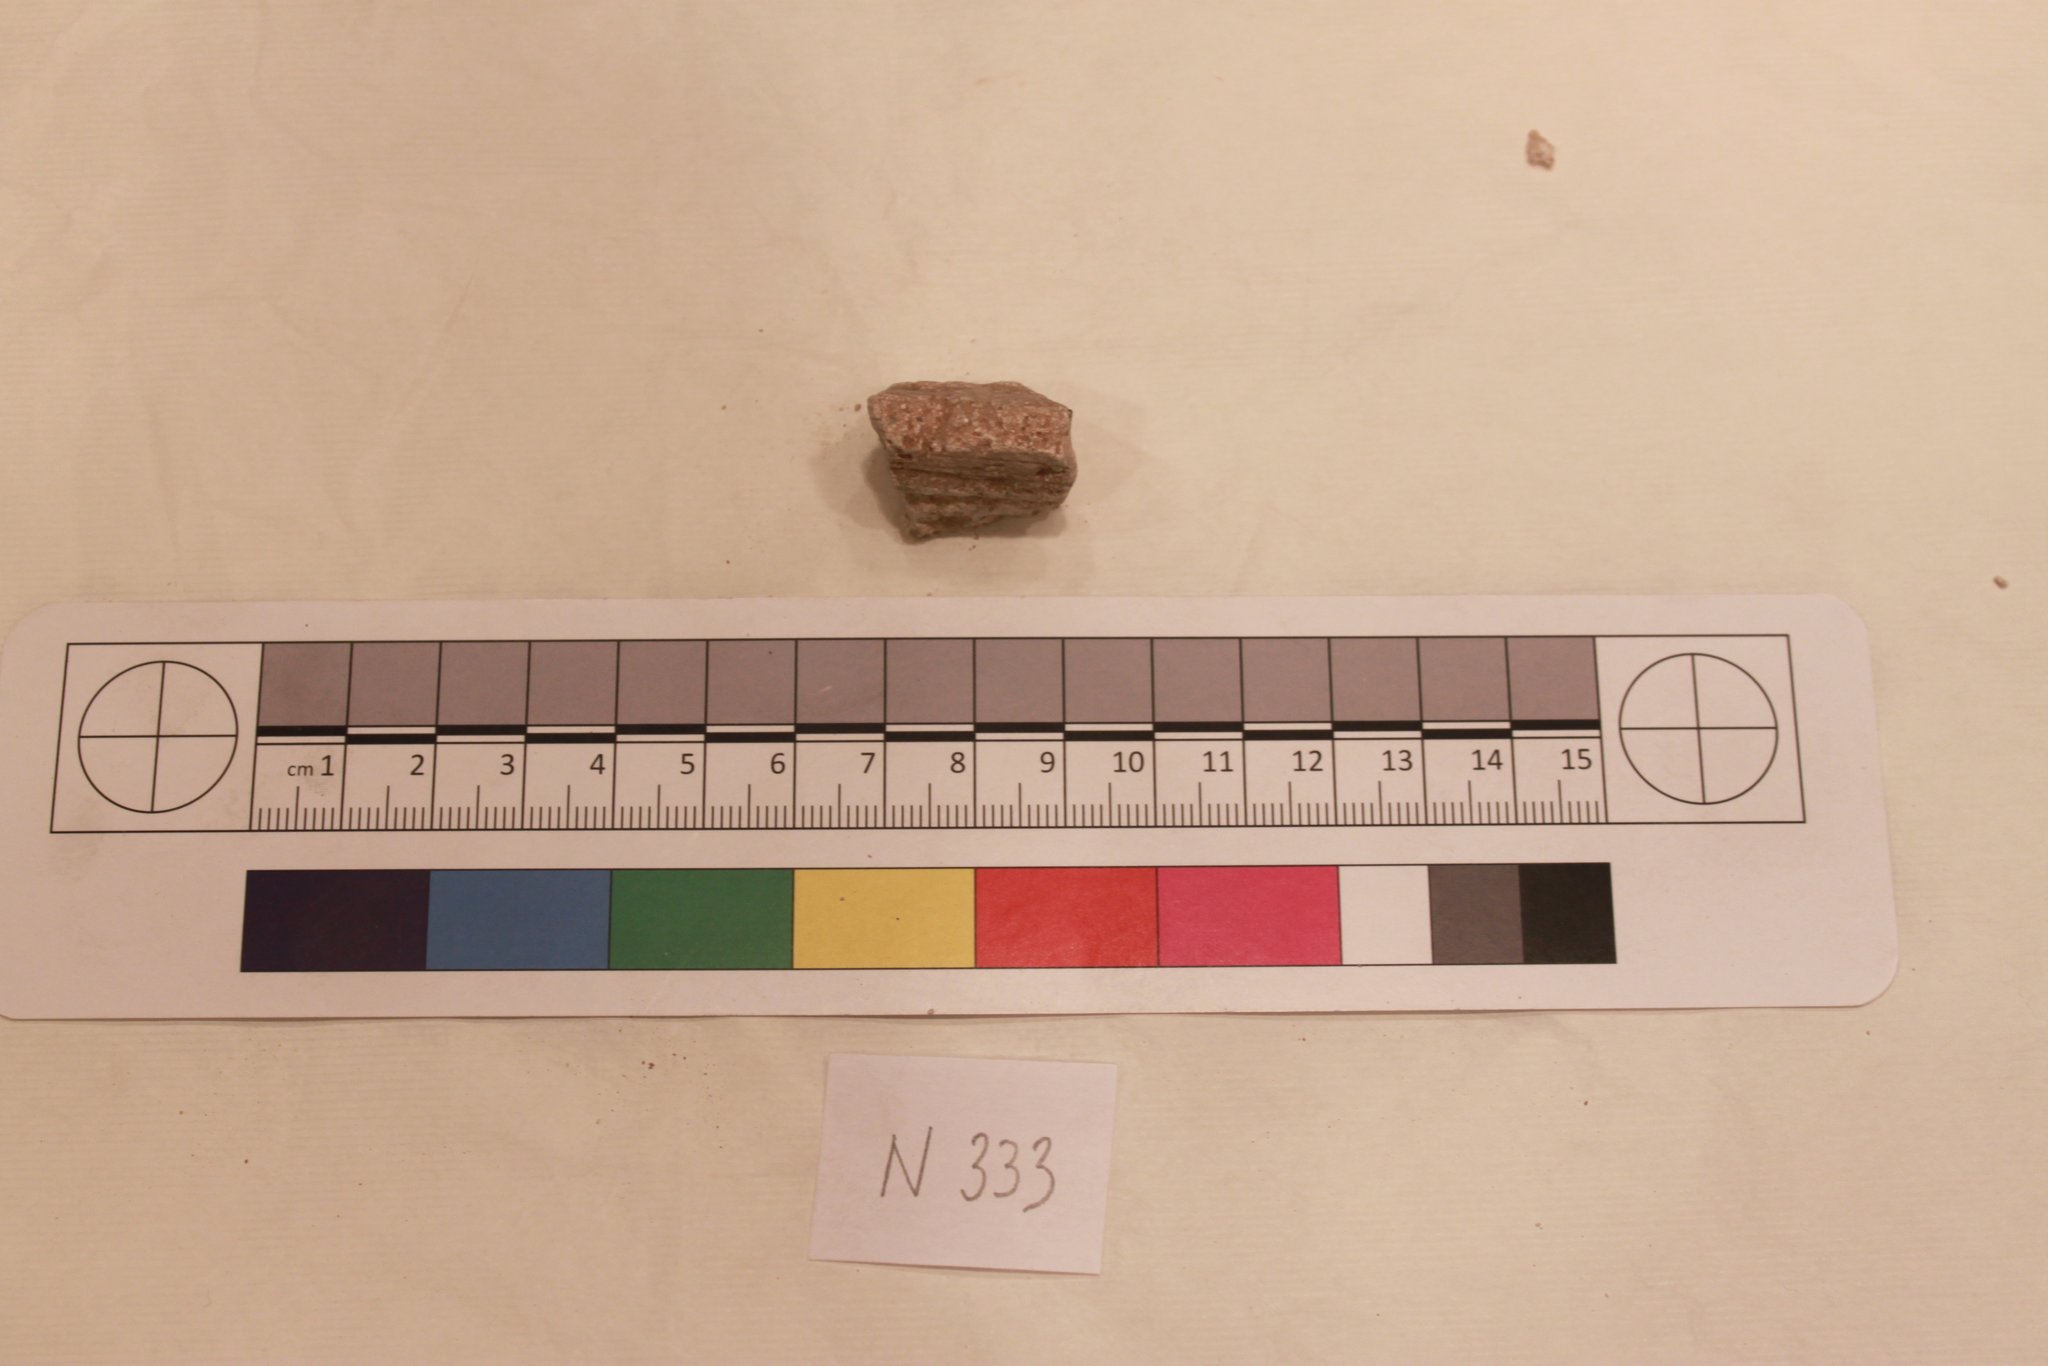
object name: fragment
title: Stucco Fragment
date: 701-1200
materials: plaster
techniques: carving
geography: iran